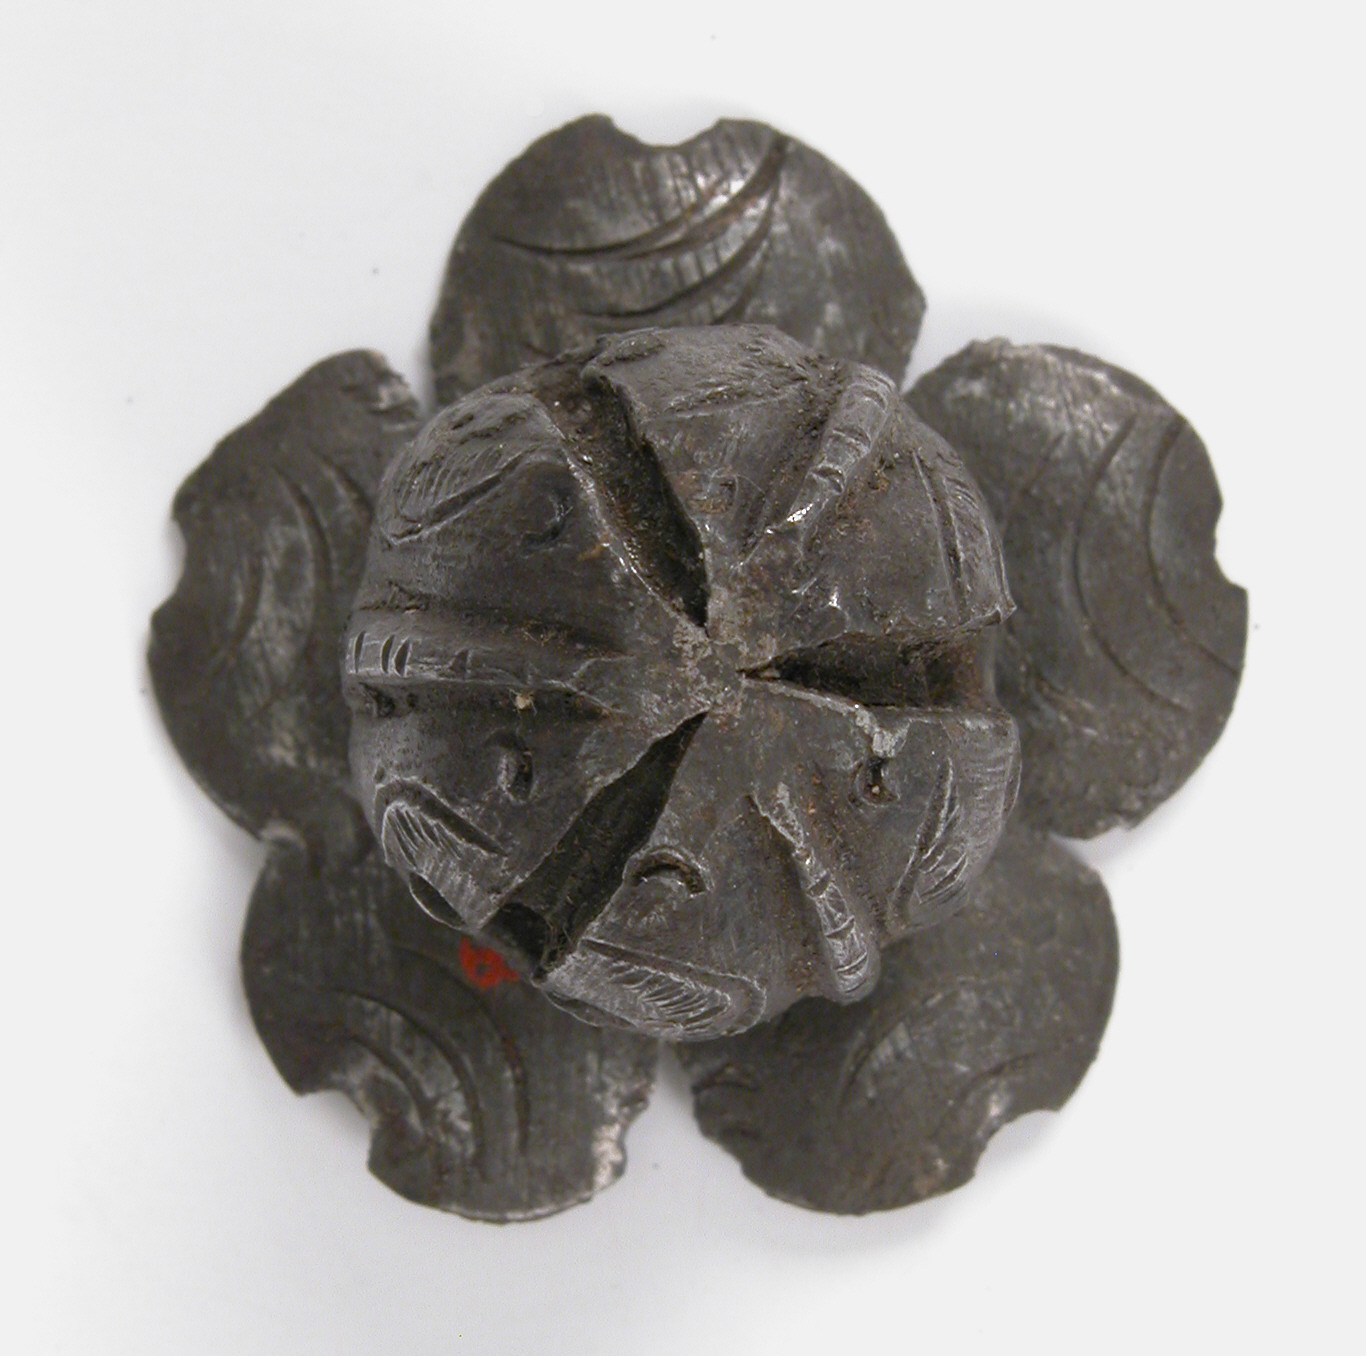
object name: nail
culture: german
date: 1501-1600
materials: iron